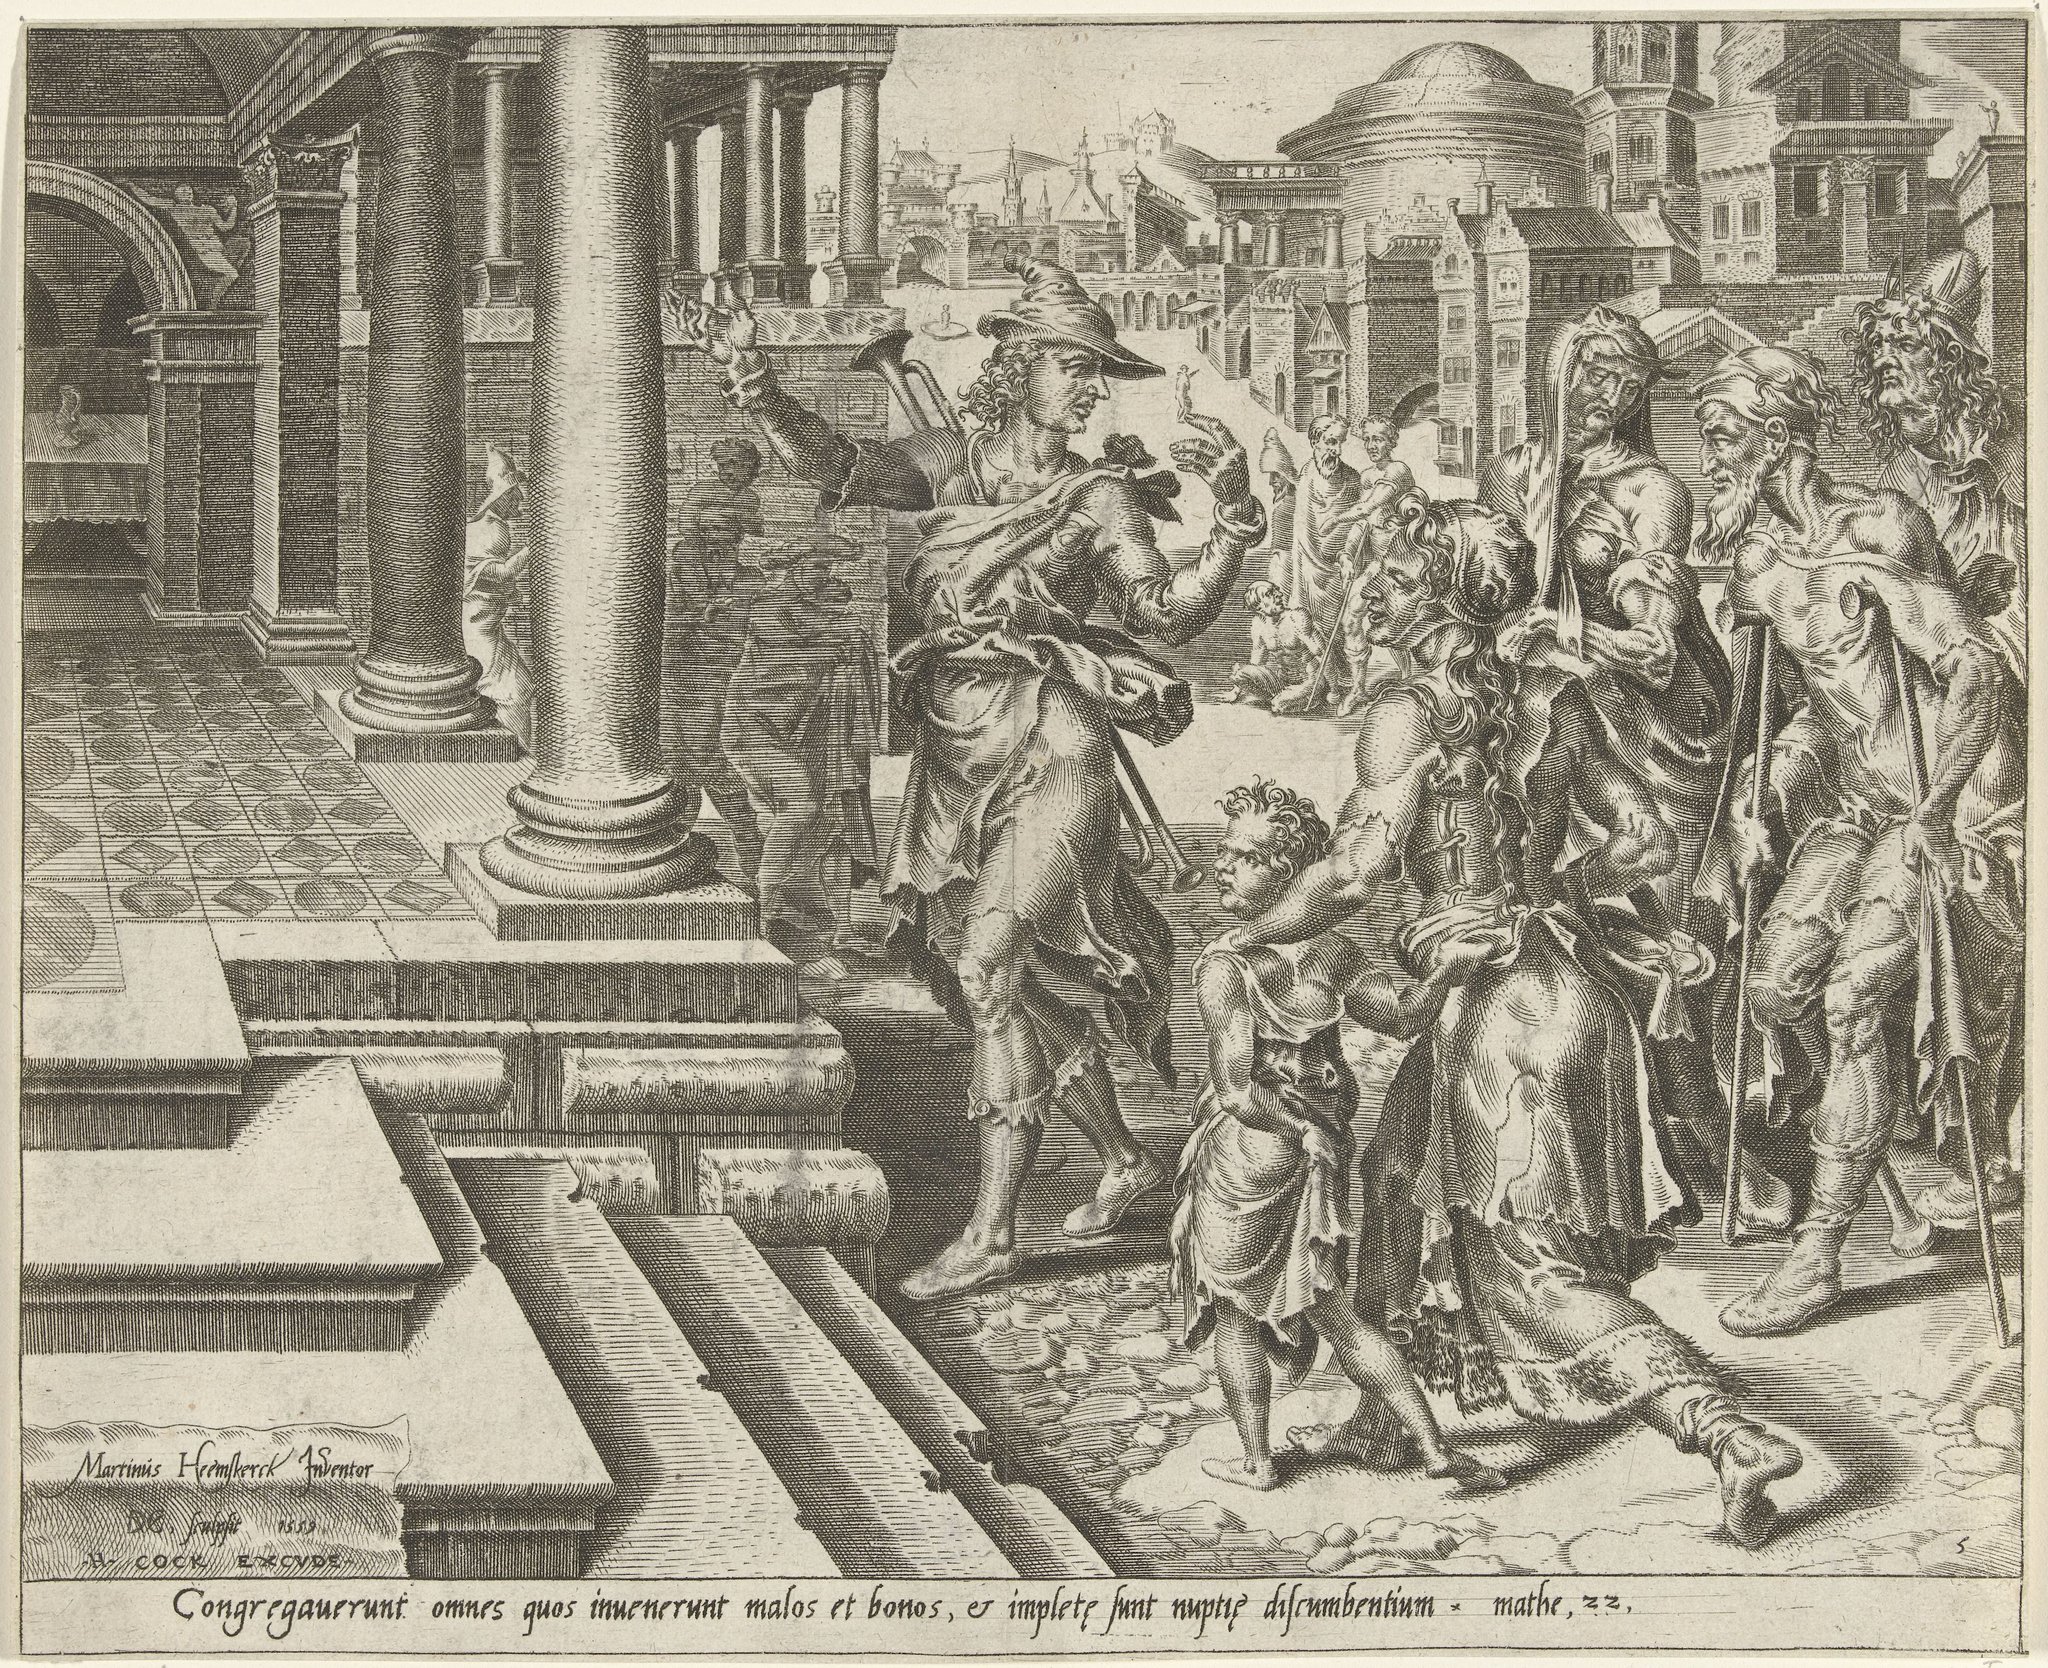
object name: print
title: Uitnodiging voor de zieken en armen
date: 1559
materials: paper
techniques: engraving, etching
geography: antwerp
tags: horn, trumpet, cornet, trombone, tuba, person with a physical disability, messenger, gallery (spacious corridor), poor, maimed, blind and lame are brought in, and sit down at the table ~ parable of the royal wedding-feast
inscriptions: collector's mark: Lugt 2228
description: De boodschapper van de koning nodigt alle zieken en armen van de stad uit om naar het bruiloftsfeest van de koning te komen. De prent heeft een Latijns onderschrift en maakt deel uit van een zesdelige serie over de gelijkenis van een bruiloftsfeest.